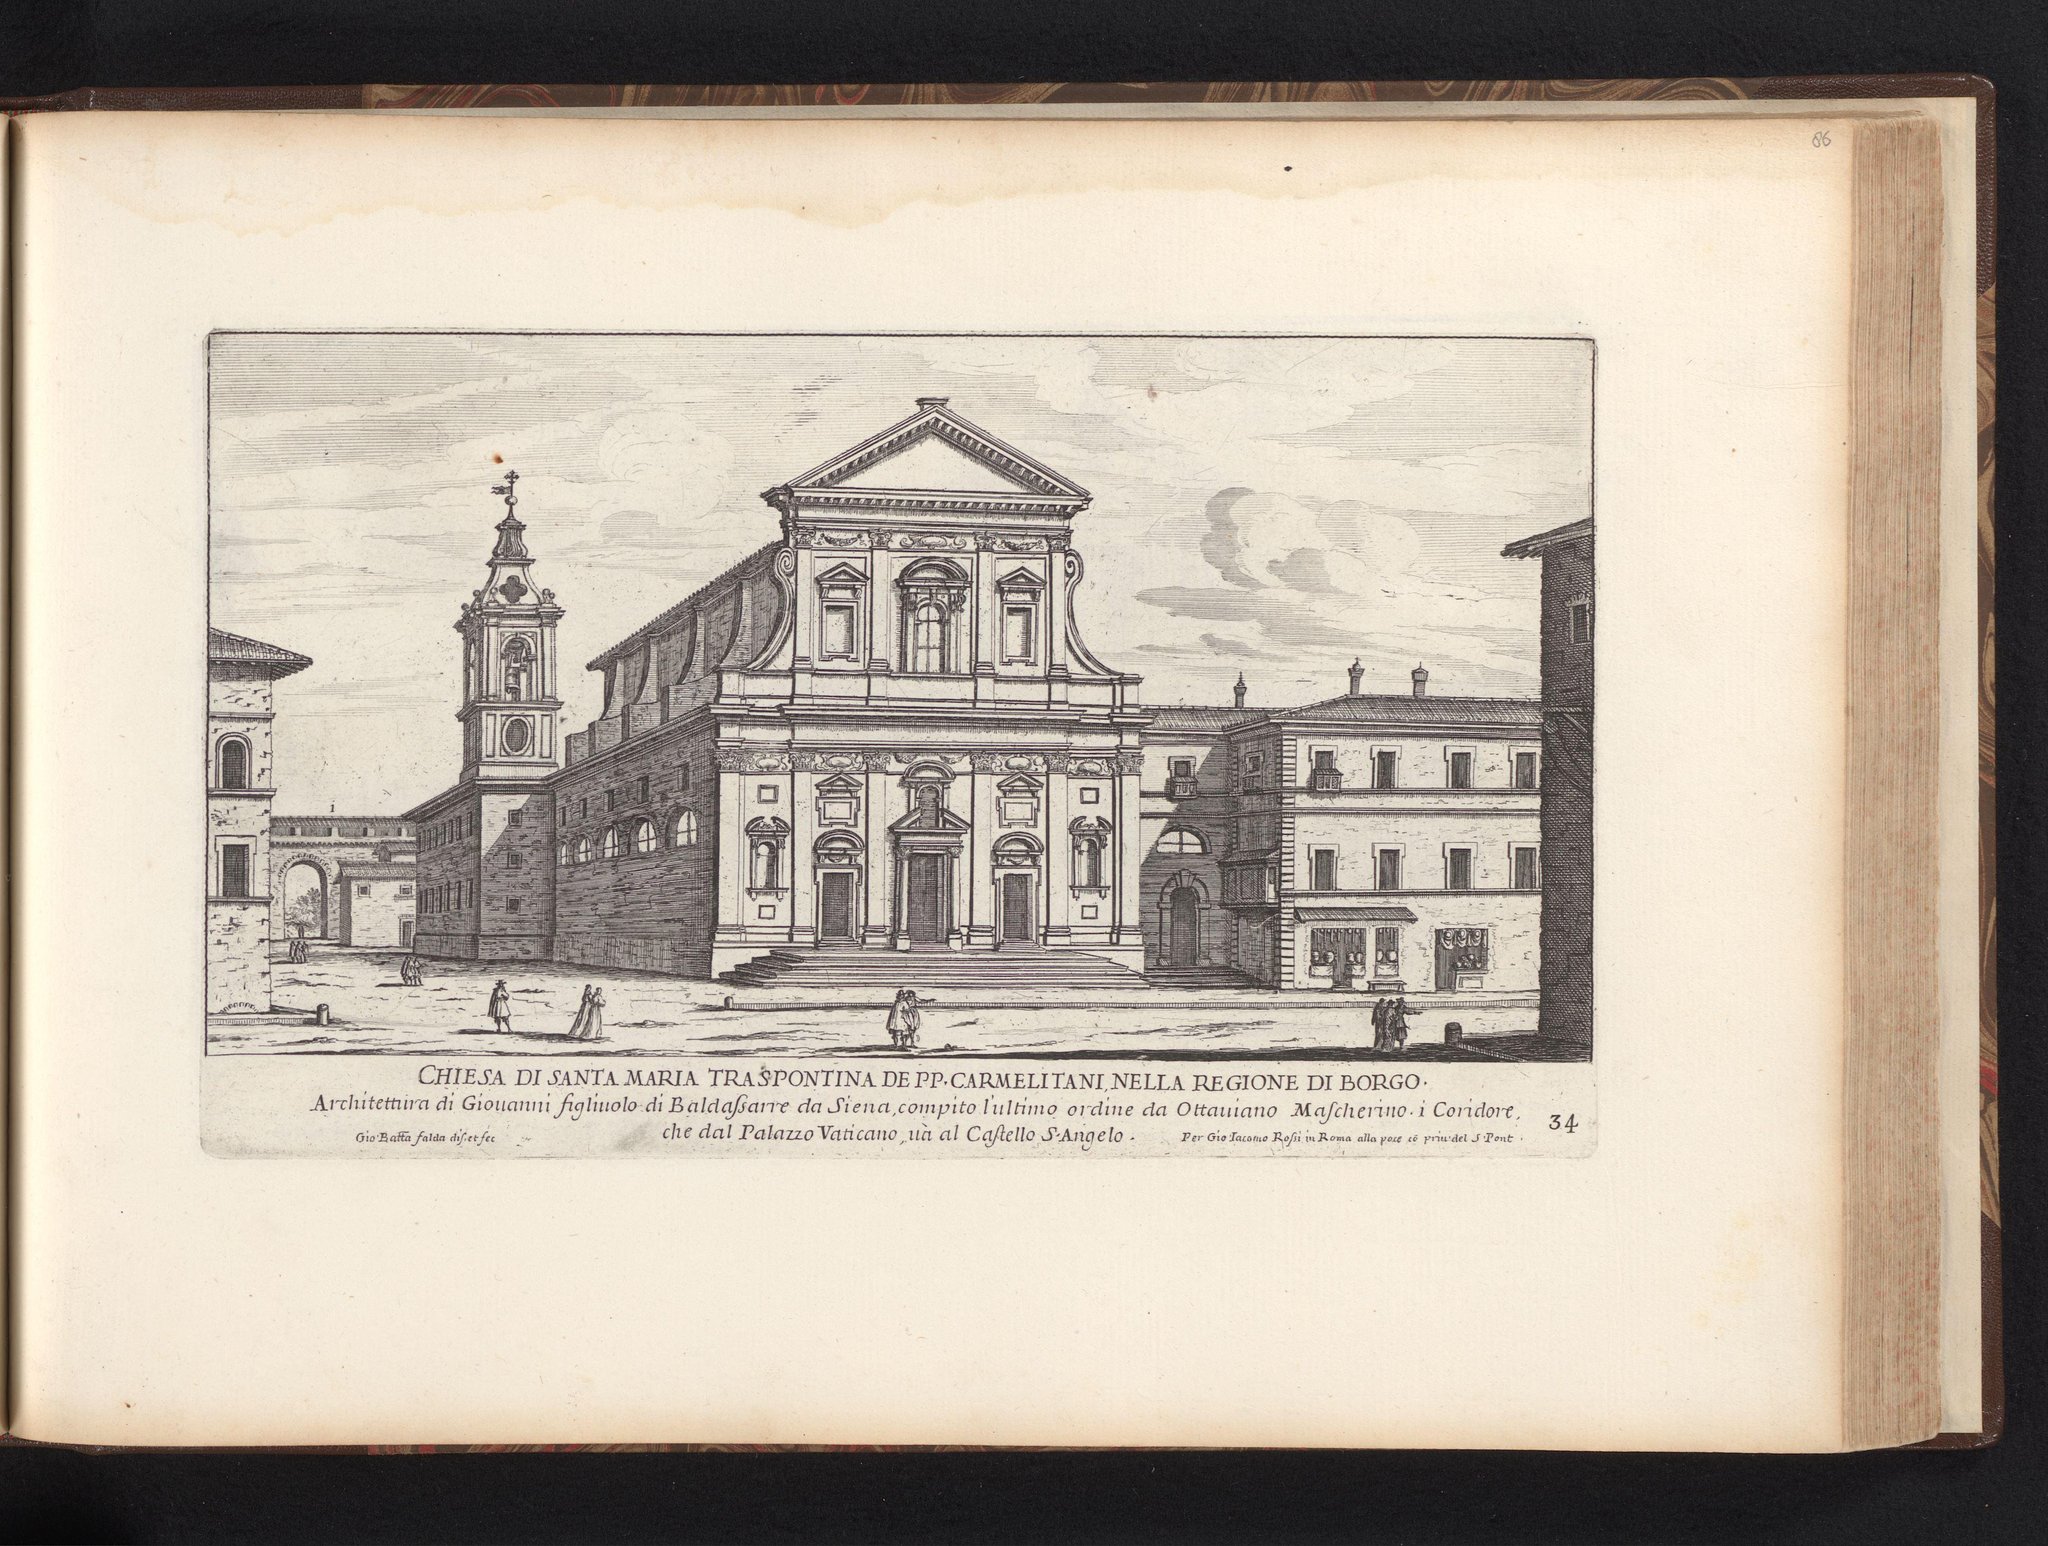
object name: album leaf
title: Chiesa di Santa Maria Traspontina de pp. Carmelitani nella Regione di Borg (...)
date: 1669-1670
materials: paper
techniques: etching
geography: vatican city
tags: city-view, and landscape with man-made constructions, church (exterior)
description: Deze titelprent maakt deel uit van een reeks van 38 prenten met voorstellingen van kerken in Rome. Samen met vier andere reeksen vormt het de grote reeks: 'Il nuovo teatro di Roma moderna'.